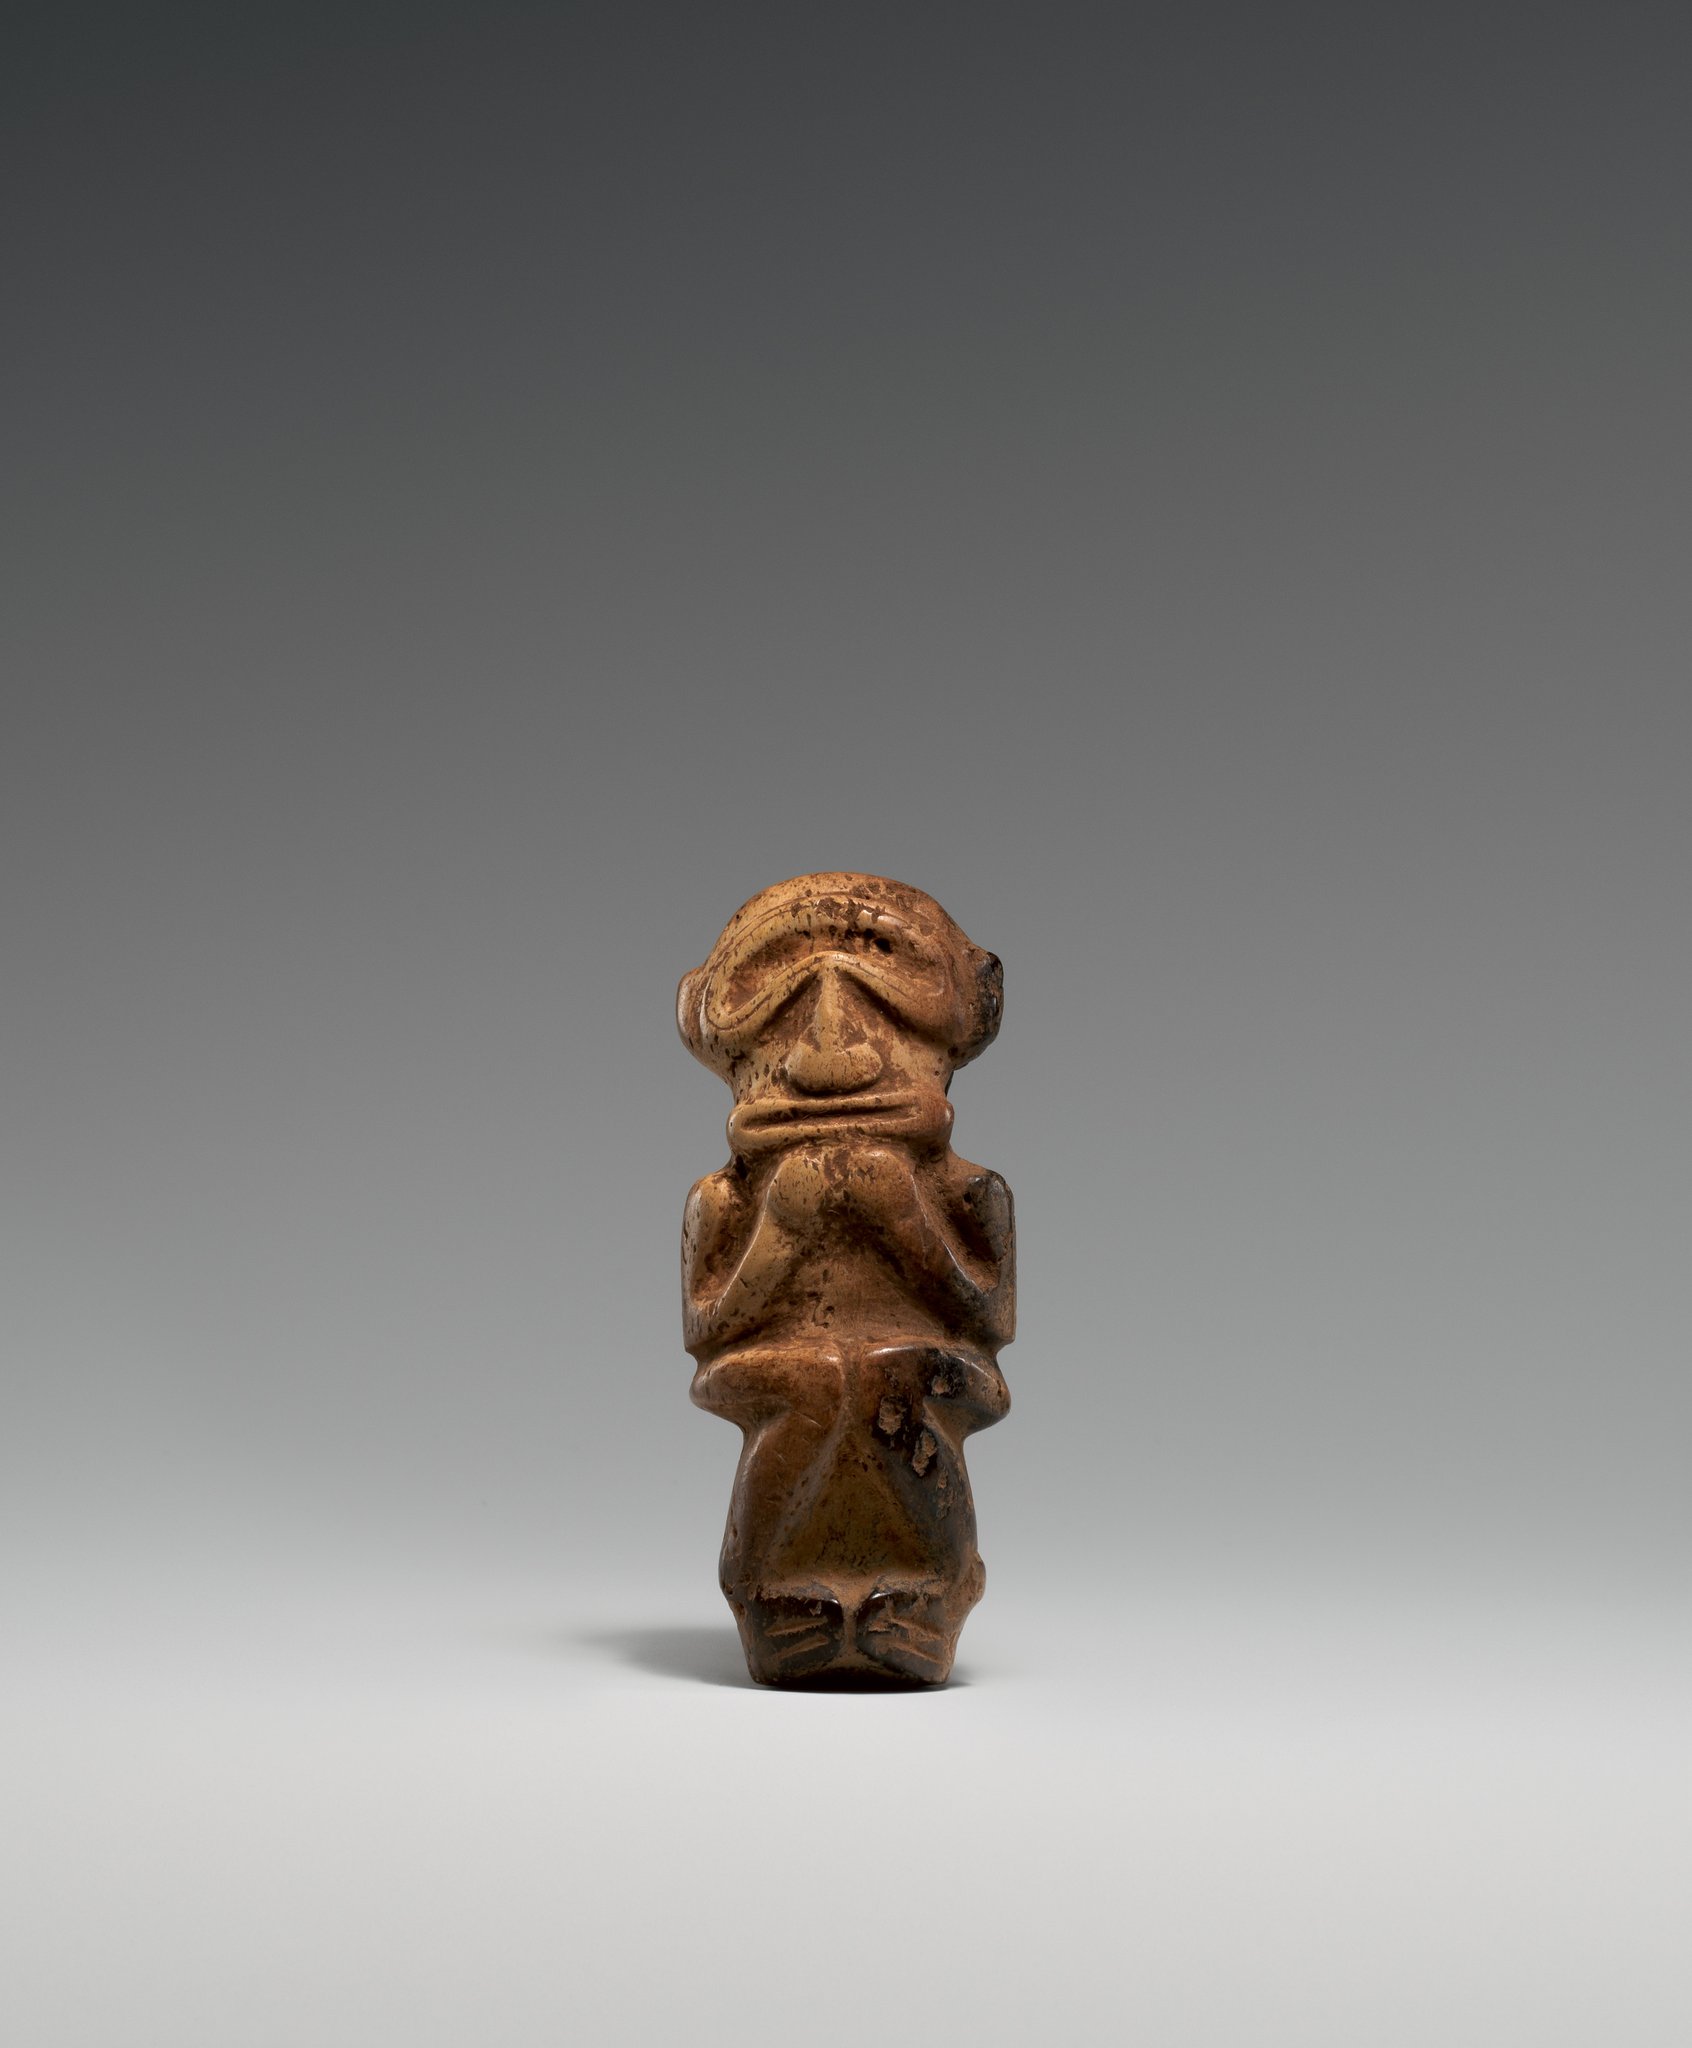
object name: pendant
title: Figure Pendant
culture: taíno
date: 1201-1500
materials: bone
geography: dominican republic